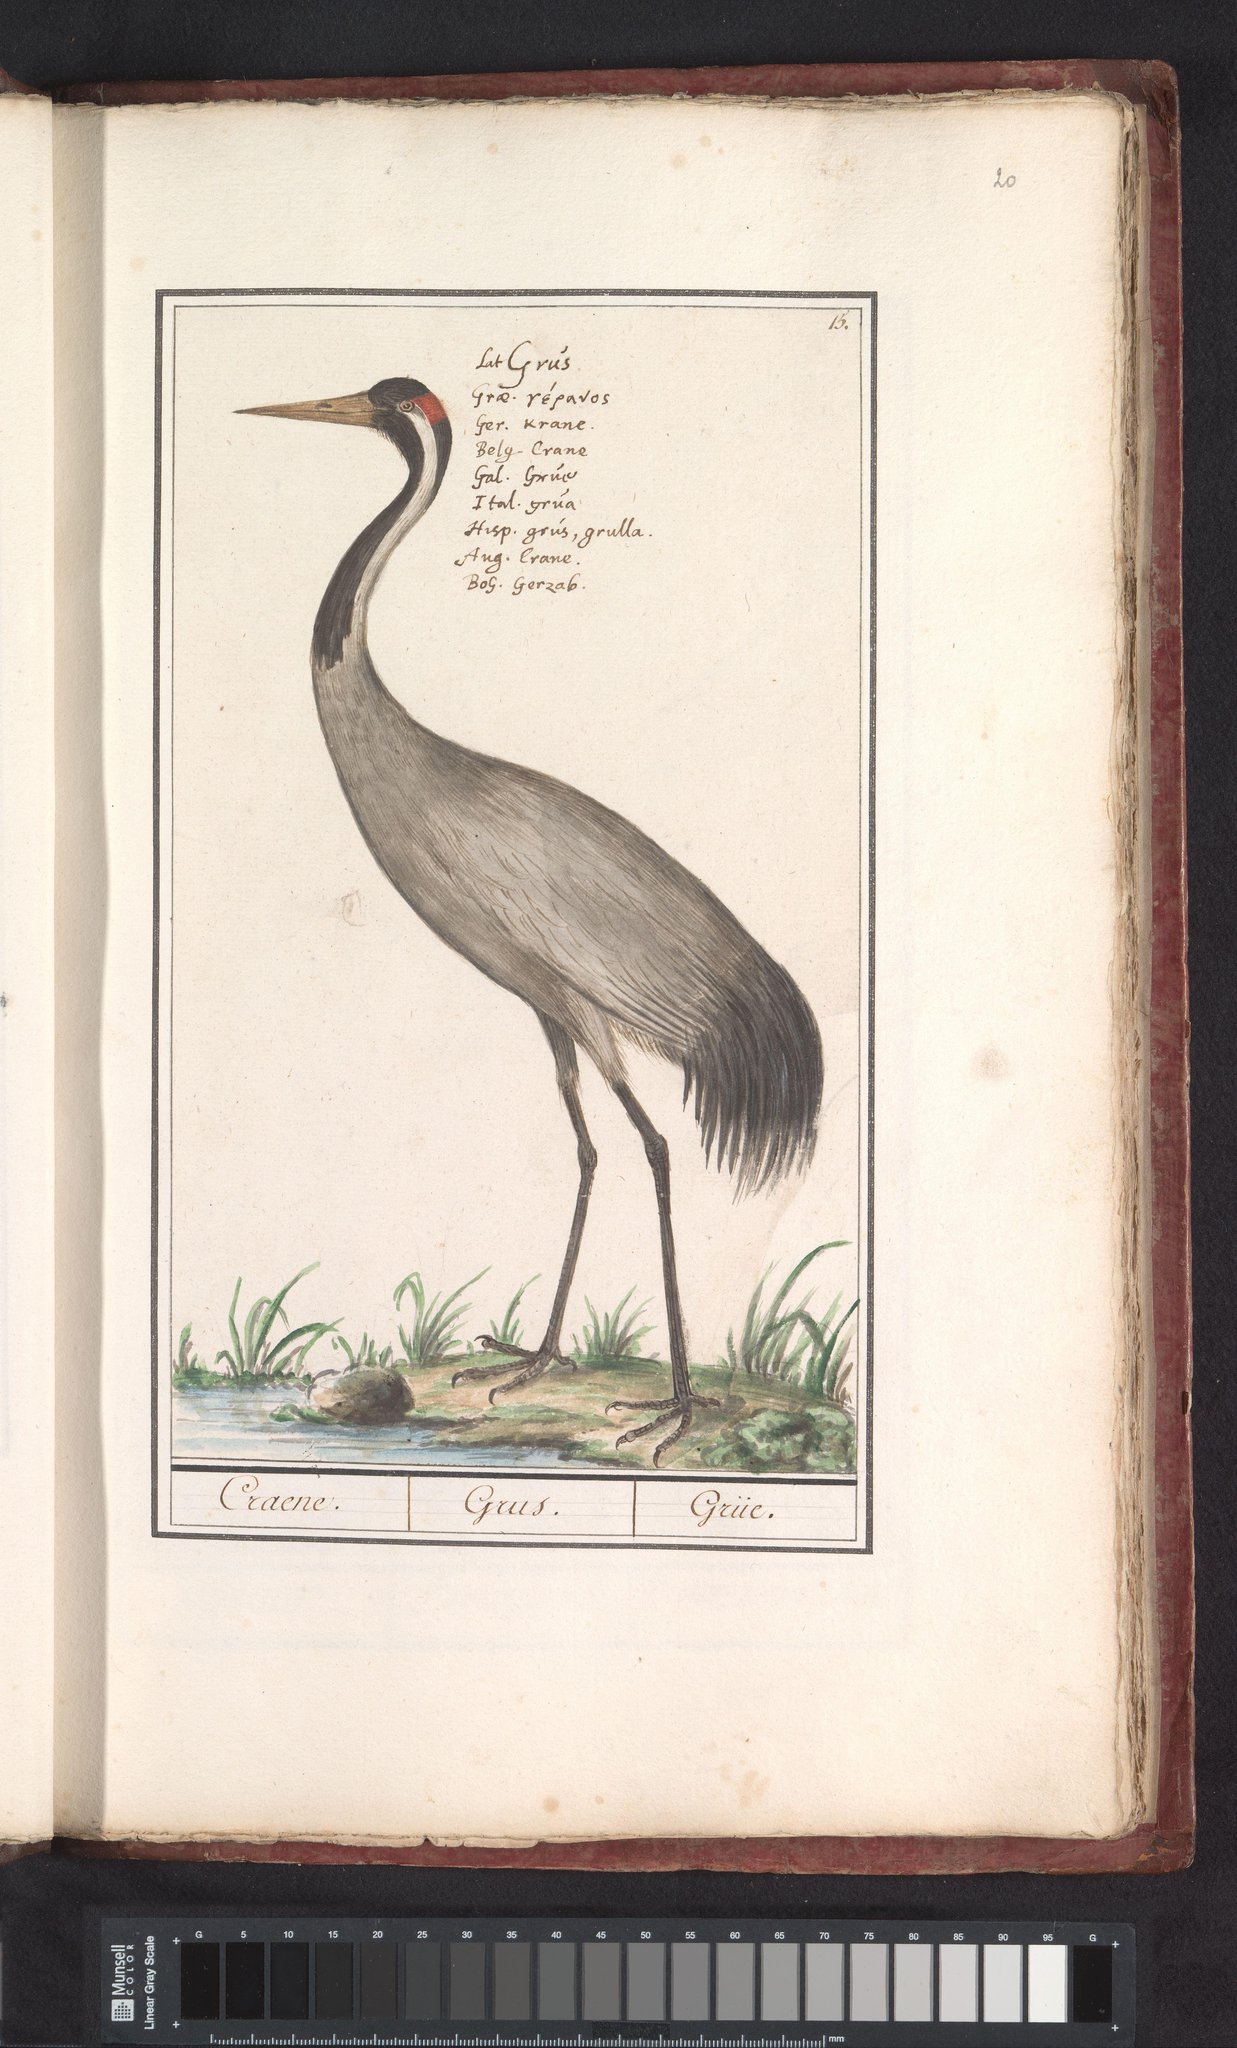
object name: drawing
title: Craene. / Grus. / Grue.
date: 1596-1610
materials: chalk, paint, ink, paper, pencil, watercolor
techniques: brush, pen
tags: shore-birds and wading-birds: crane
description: Europese kraanvogel. Genummerd rechtsboven: 15. Bovenaan de naam in negen talen. Onderdeel van het derde album met tekeningen van vogels. Vijfde van twaalf albums met tekeningen van dieren, vogels en planten bekend rond 1600, gemaakt in opdracht van keizer Rudolf II. Met toelichting in Nederlands, Latijn en Frans.